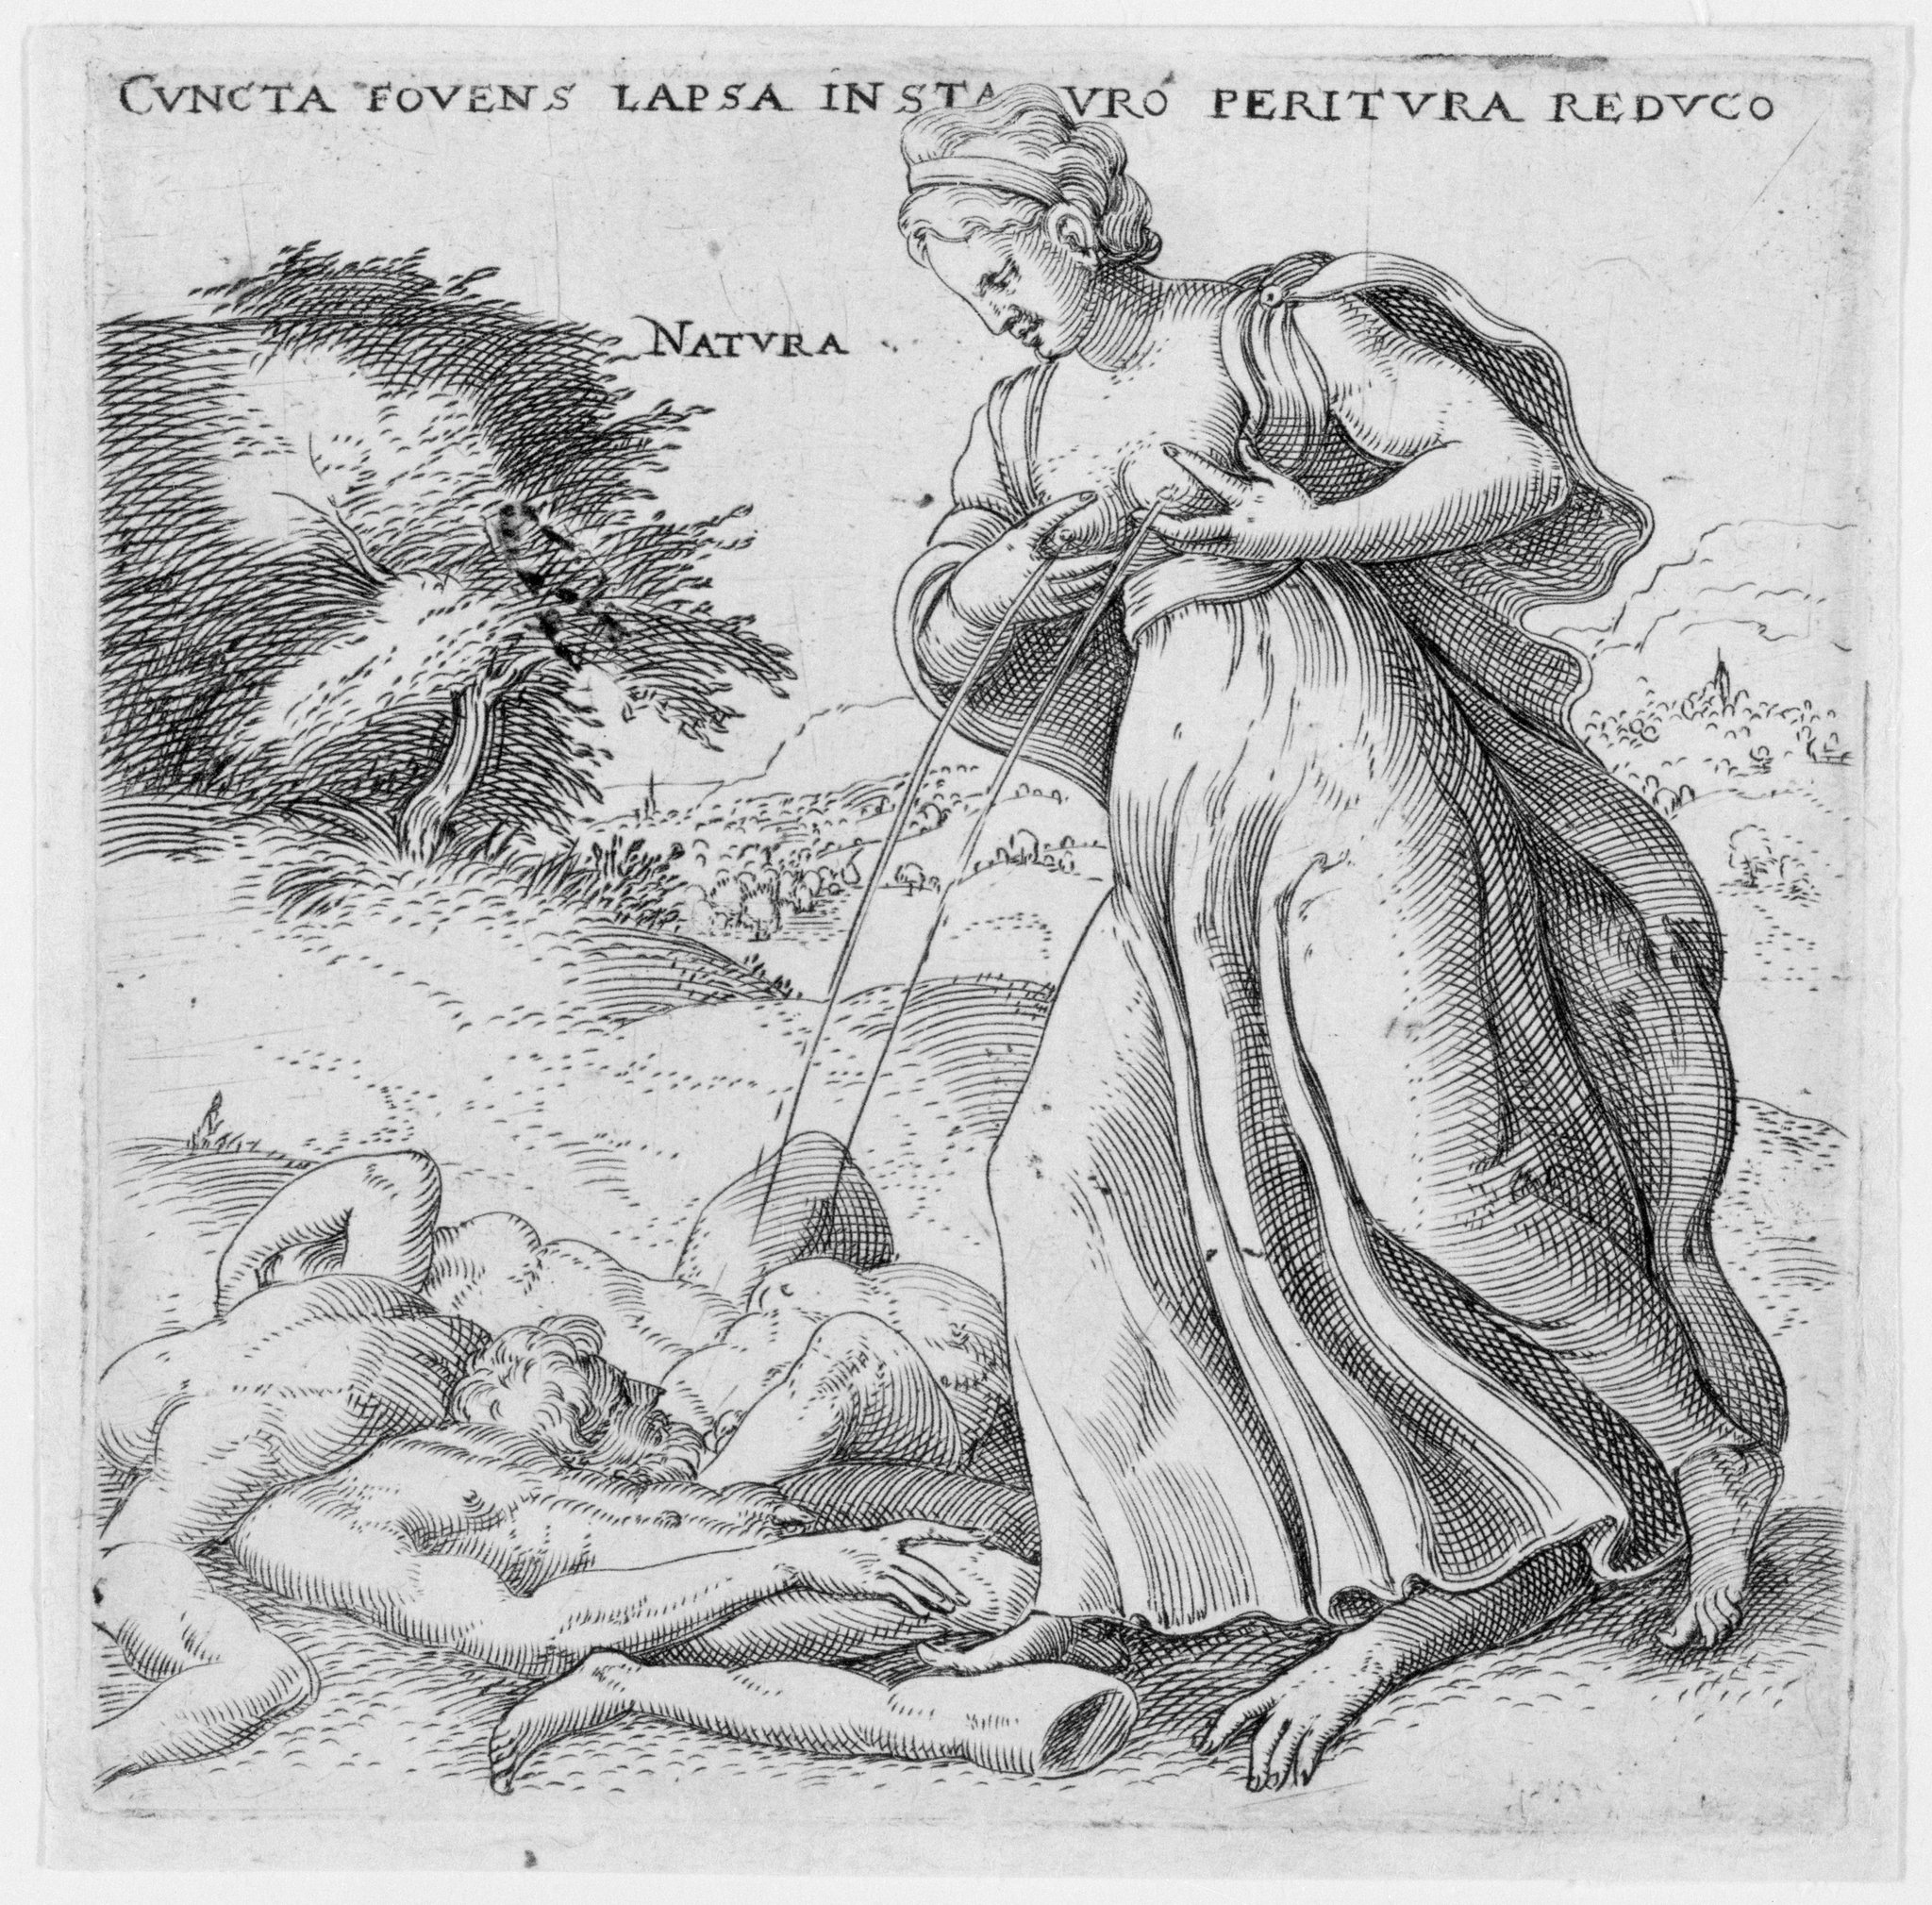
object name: print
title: Nature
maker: enea vico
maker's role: artist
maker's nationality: italian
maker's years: 1523-1567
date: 1545-1550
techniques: engraving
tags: female nudes